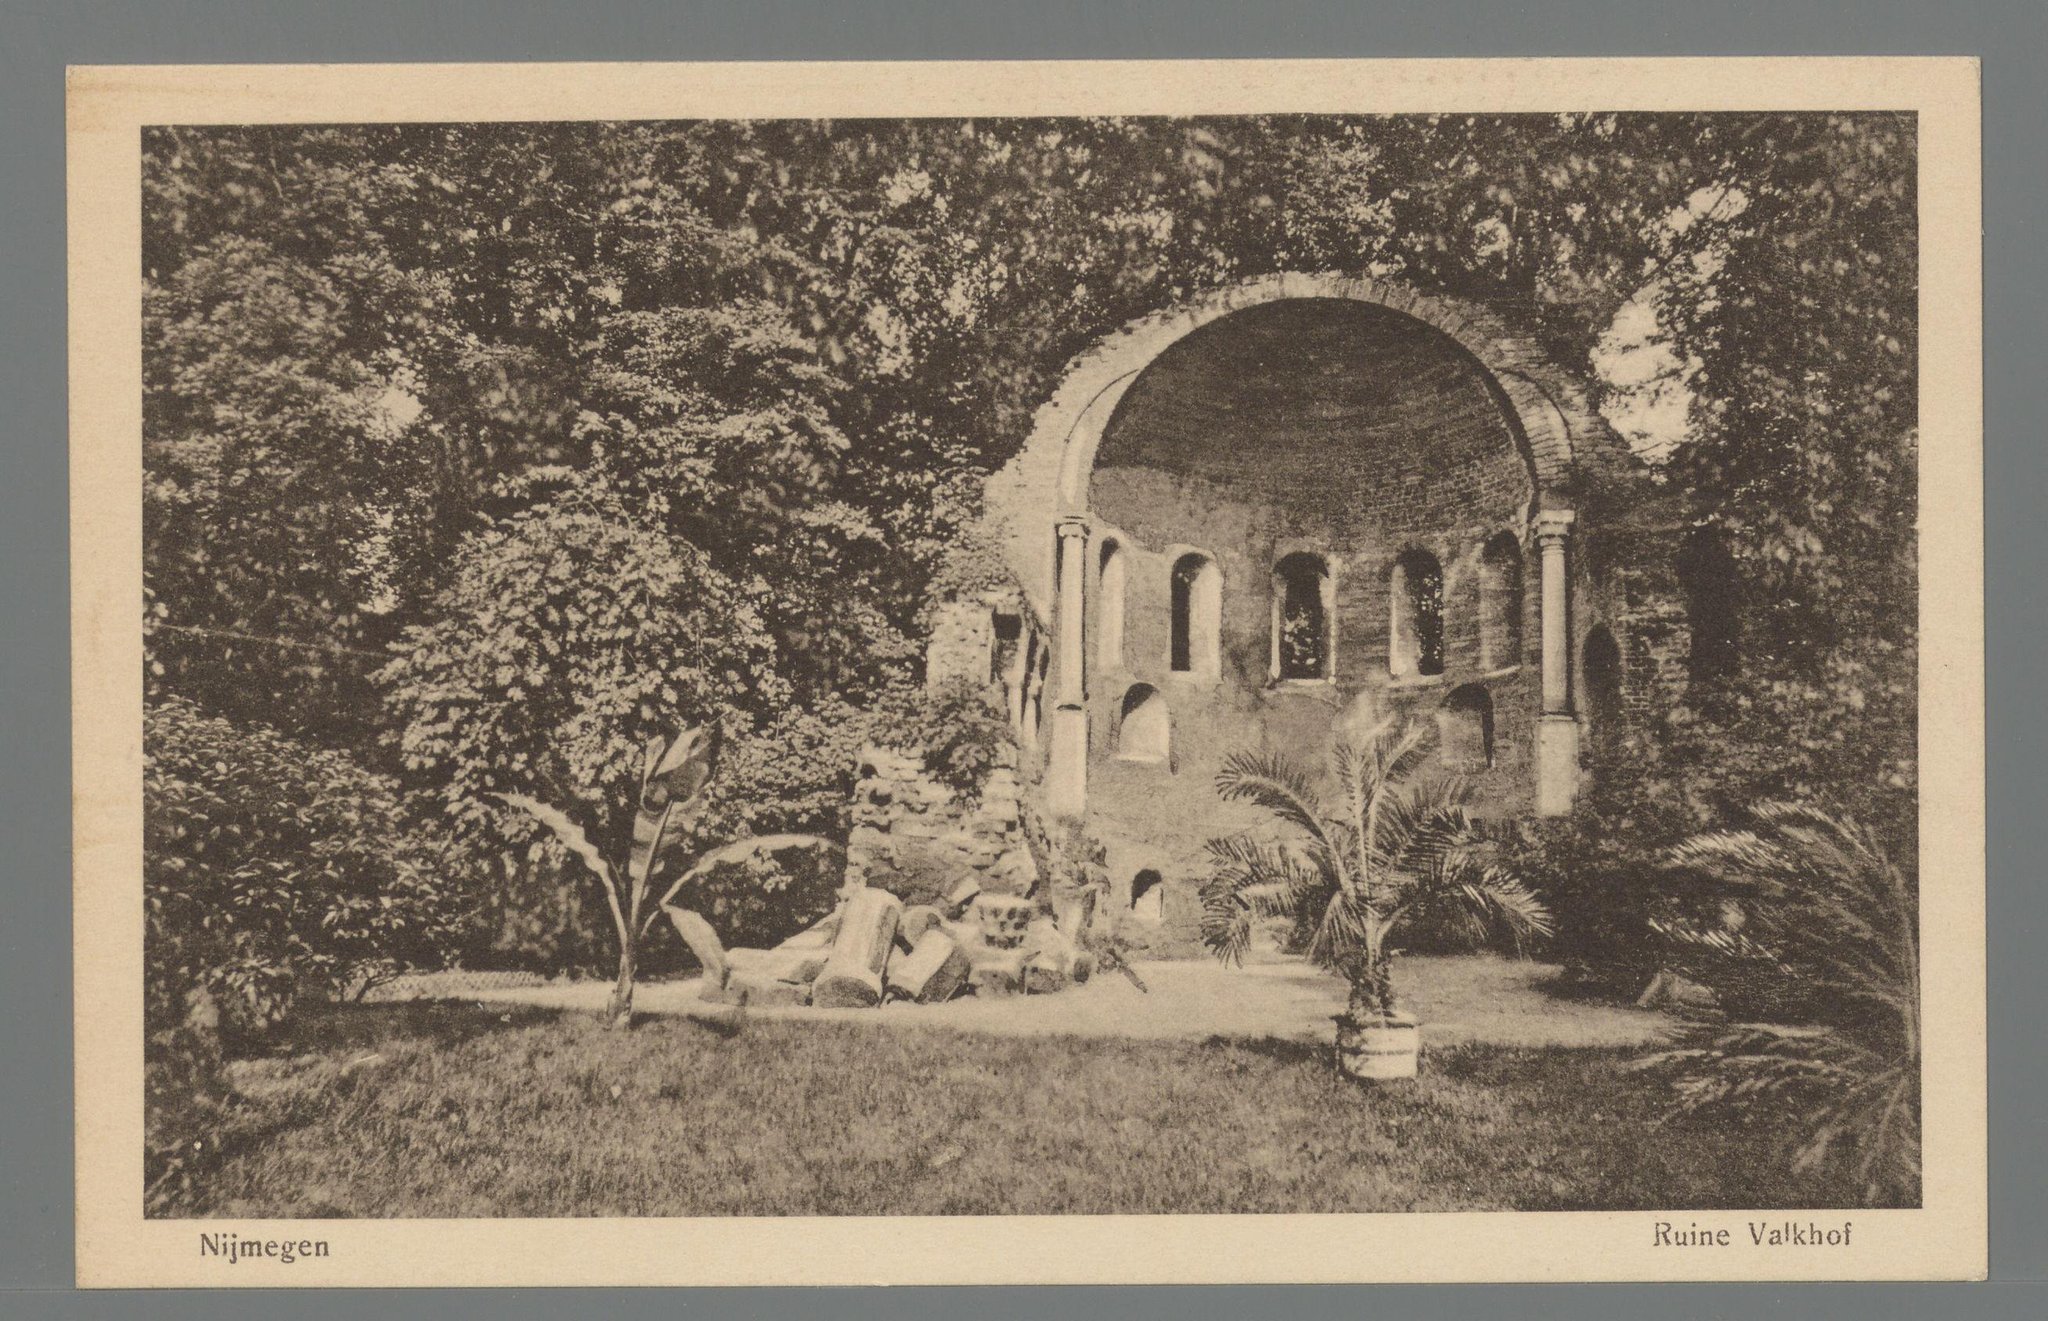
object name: ansichtkaart, prentbriefkaart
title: Nijmegen. Ruine Valkhof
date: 1913-1926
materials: cardboard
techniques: photograph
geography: amsterdam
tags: ruin of church, monastery, etc. - qq - small church, chapel, church (exterior) - qq - small church, chapel